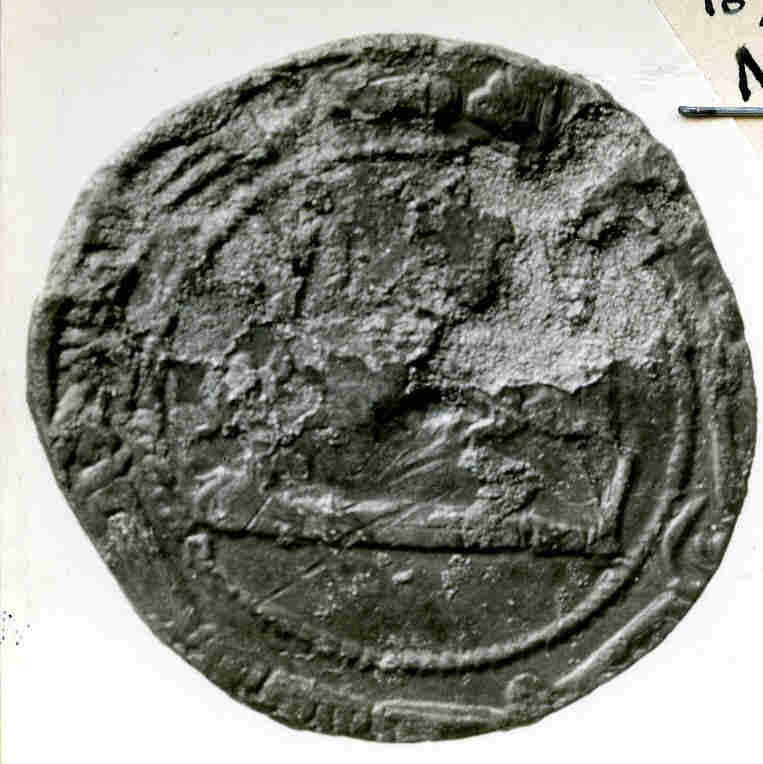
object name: coin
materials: copper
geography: al-muhammadiyya